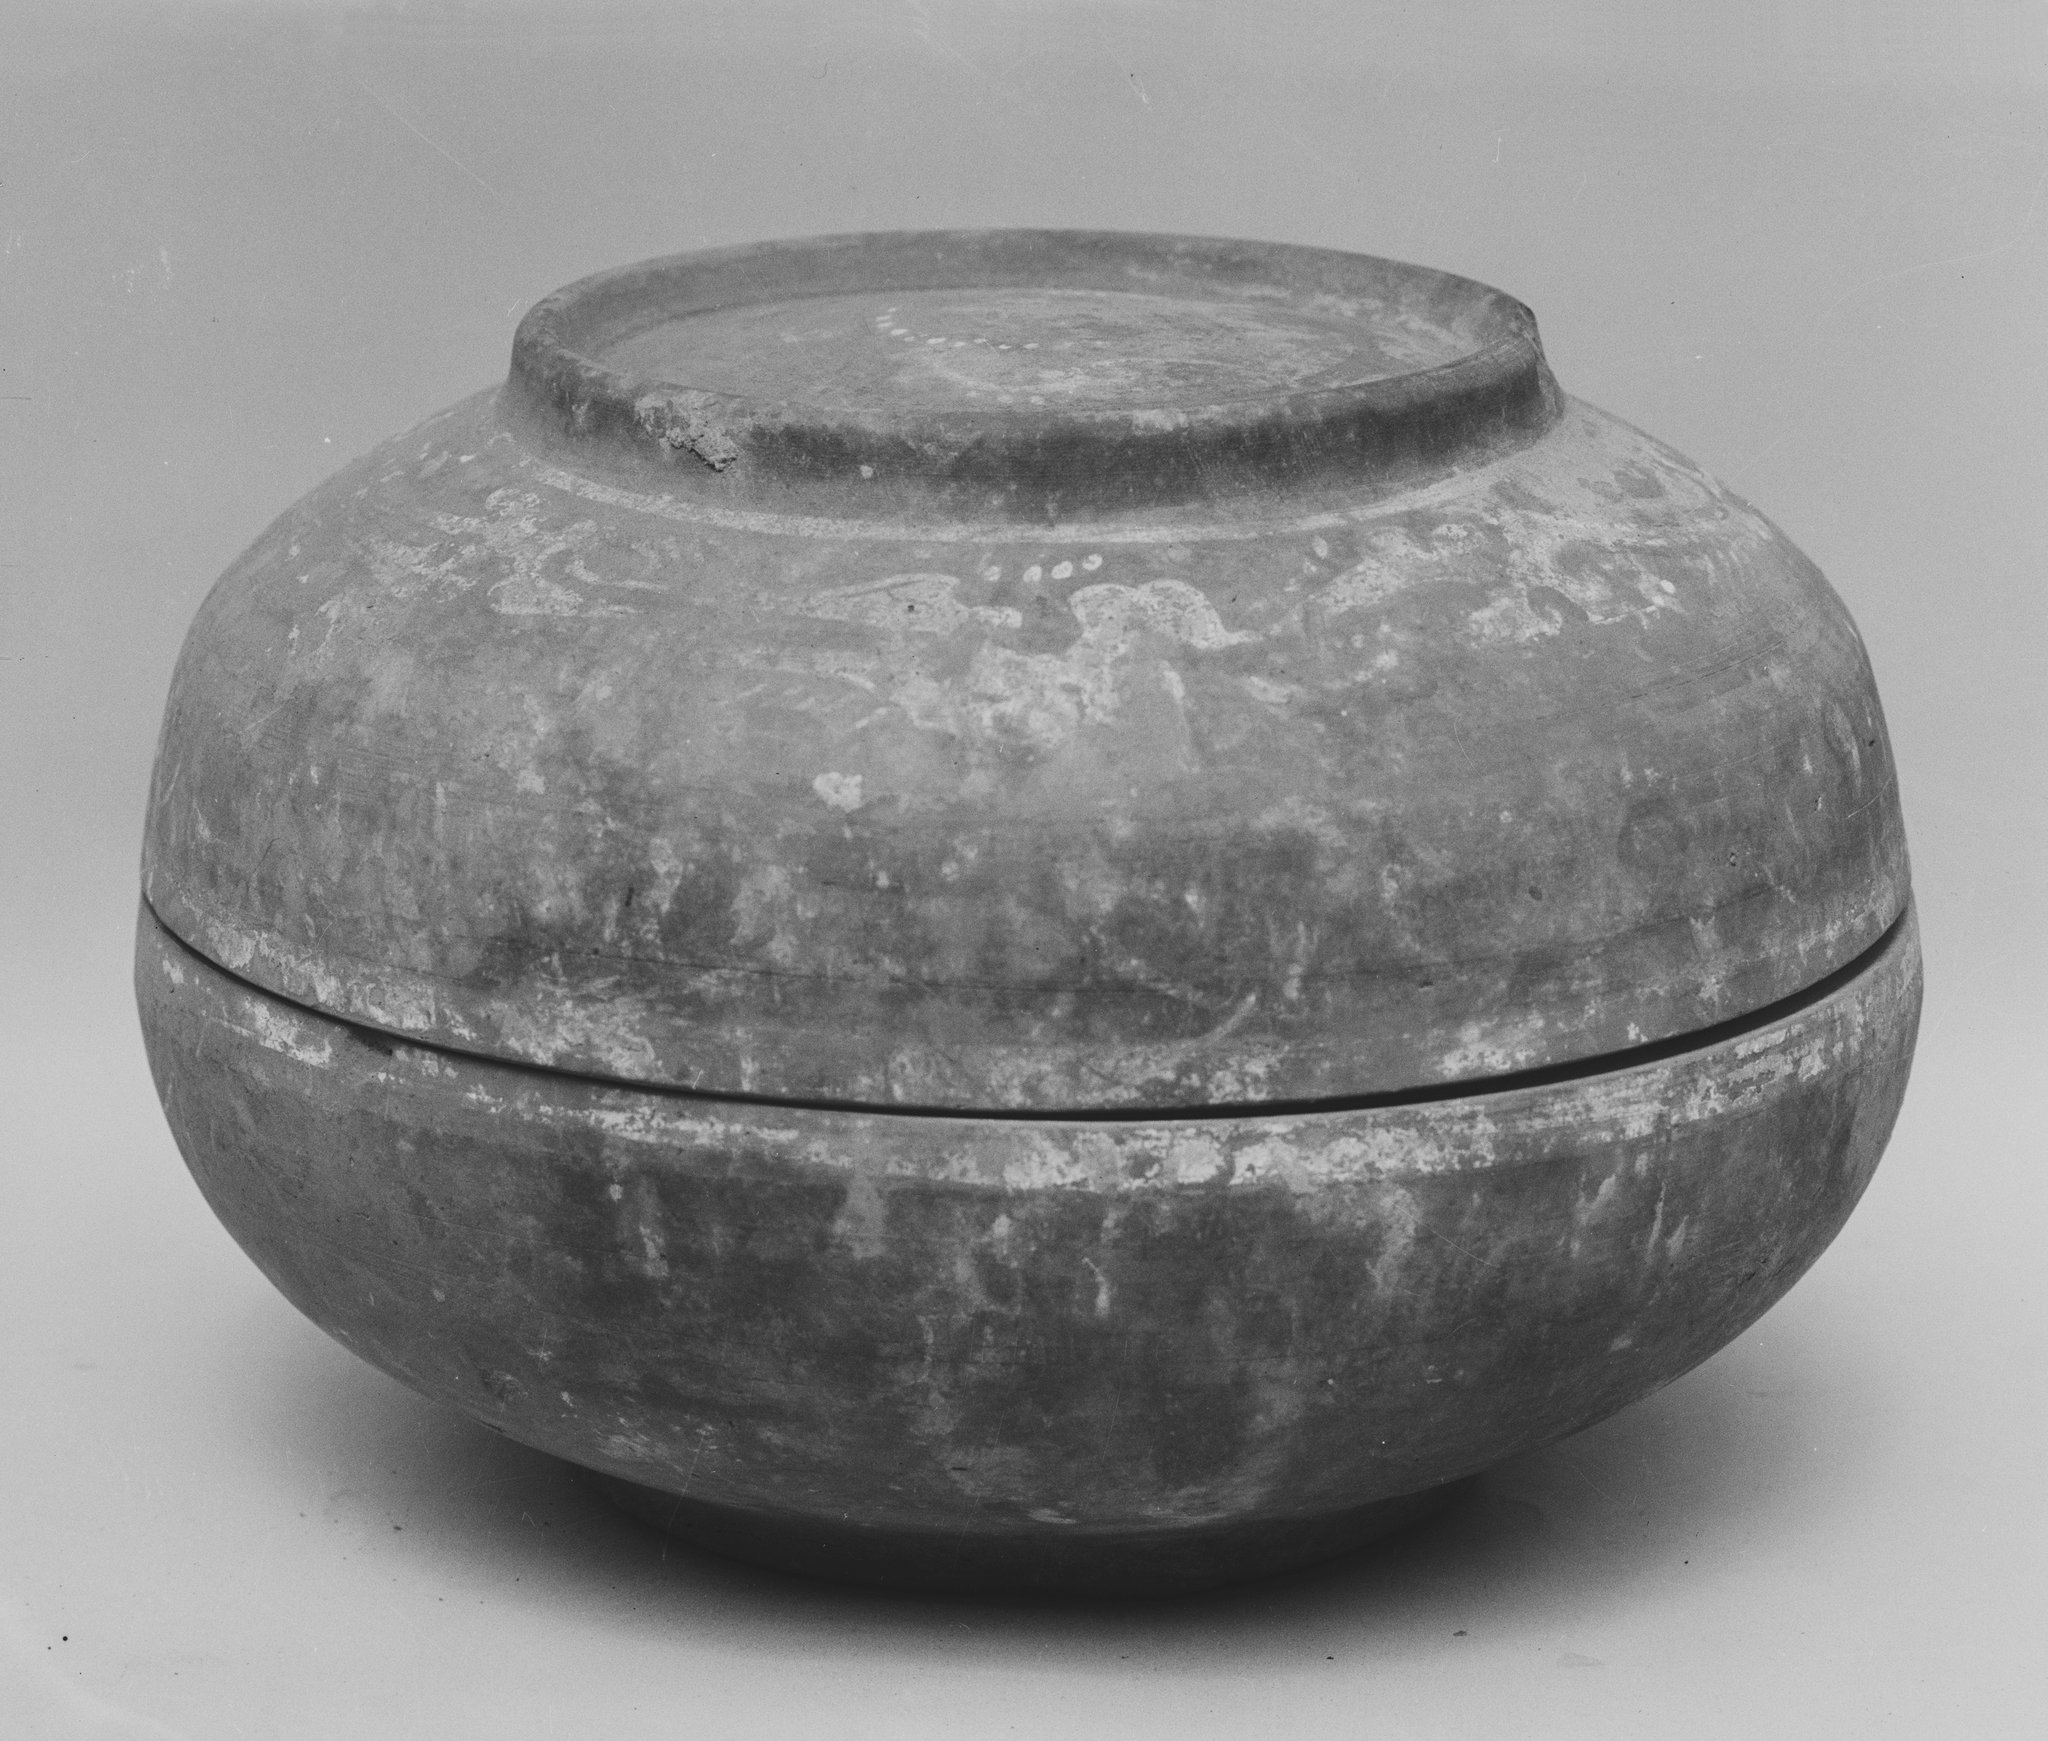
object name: covered bowl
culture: chinese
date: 206 BCE-220 CE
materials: pottery